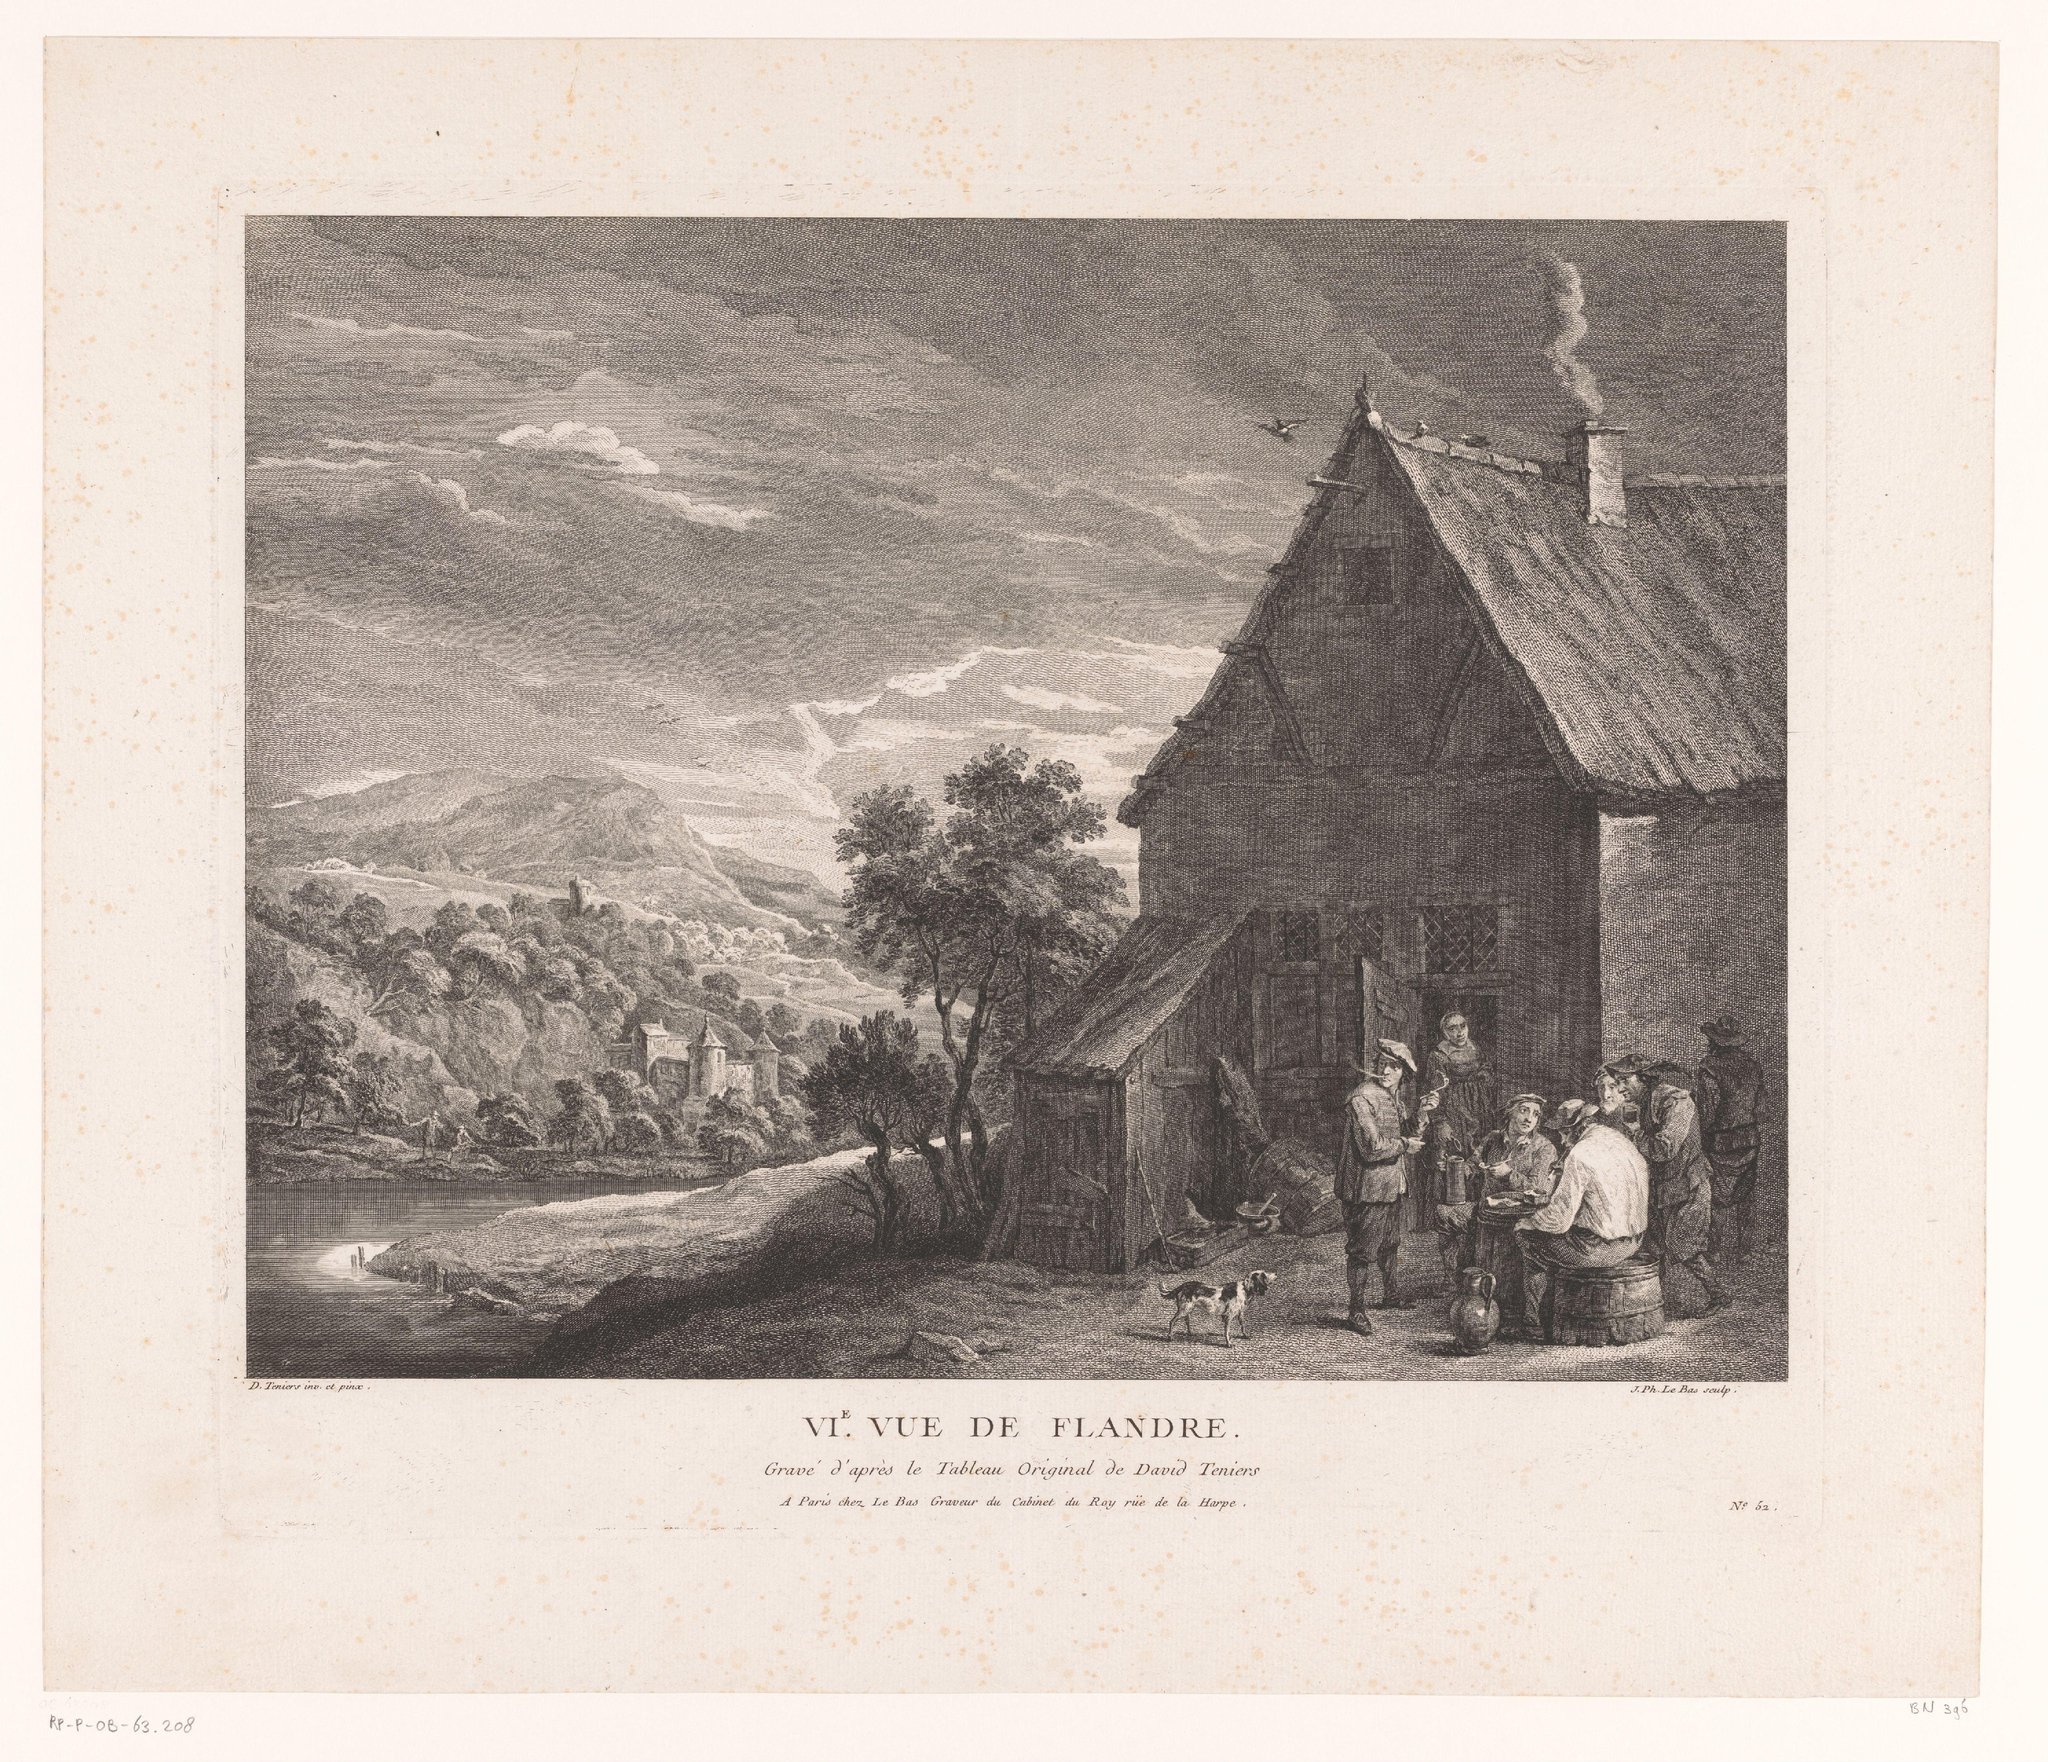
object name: print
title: Figuren voor een herberg aan een rivier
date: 1747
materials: paper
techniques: engraving, etching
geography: paris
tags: inn, coffee-house, public house, etc., hotel, hostelry, inn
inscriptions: collector's mark: Lugt 240